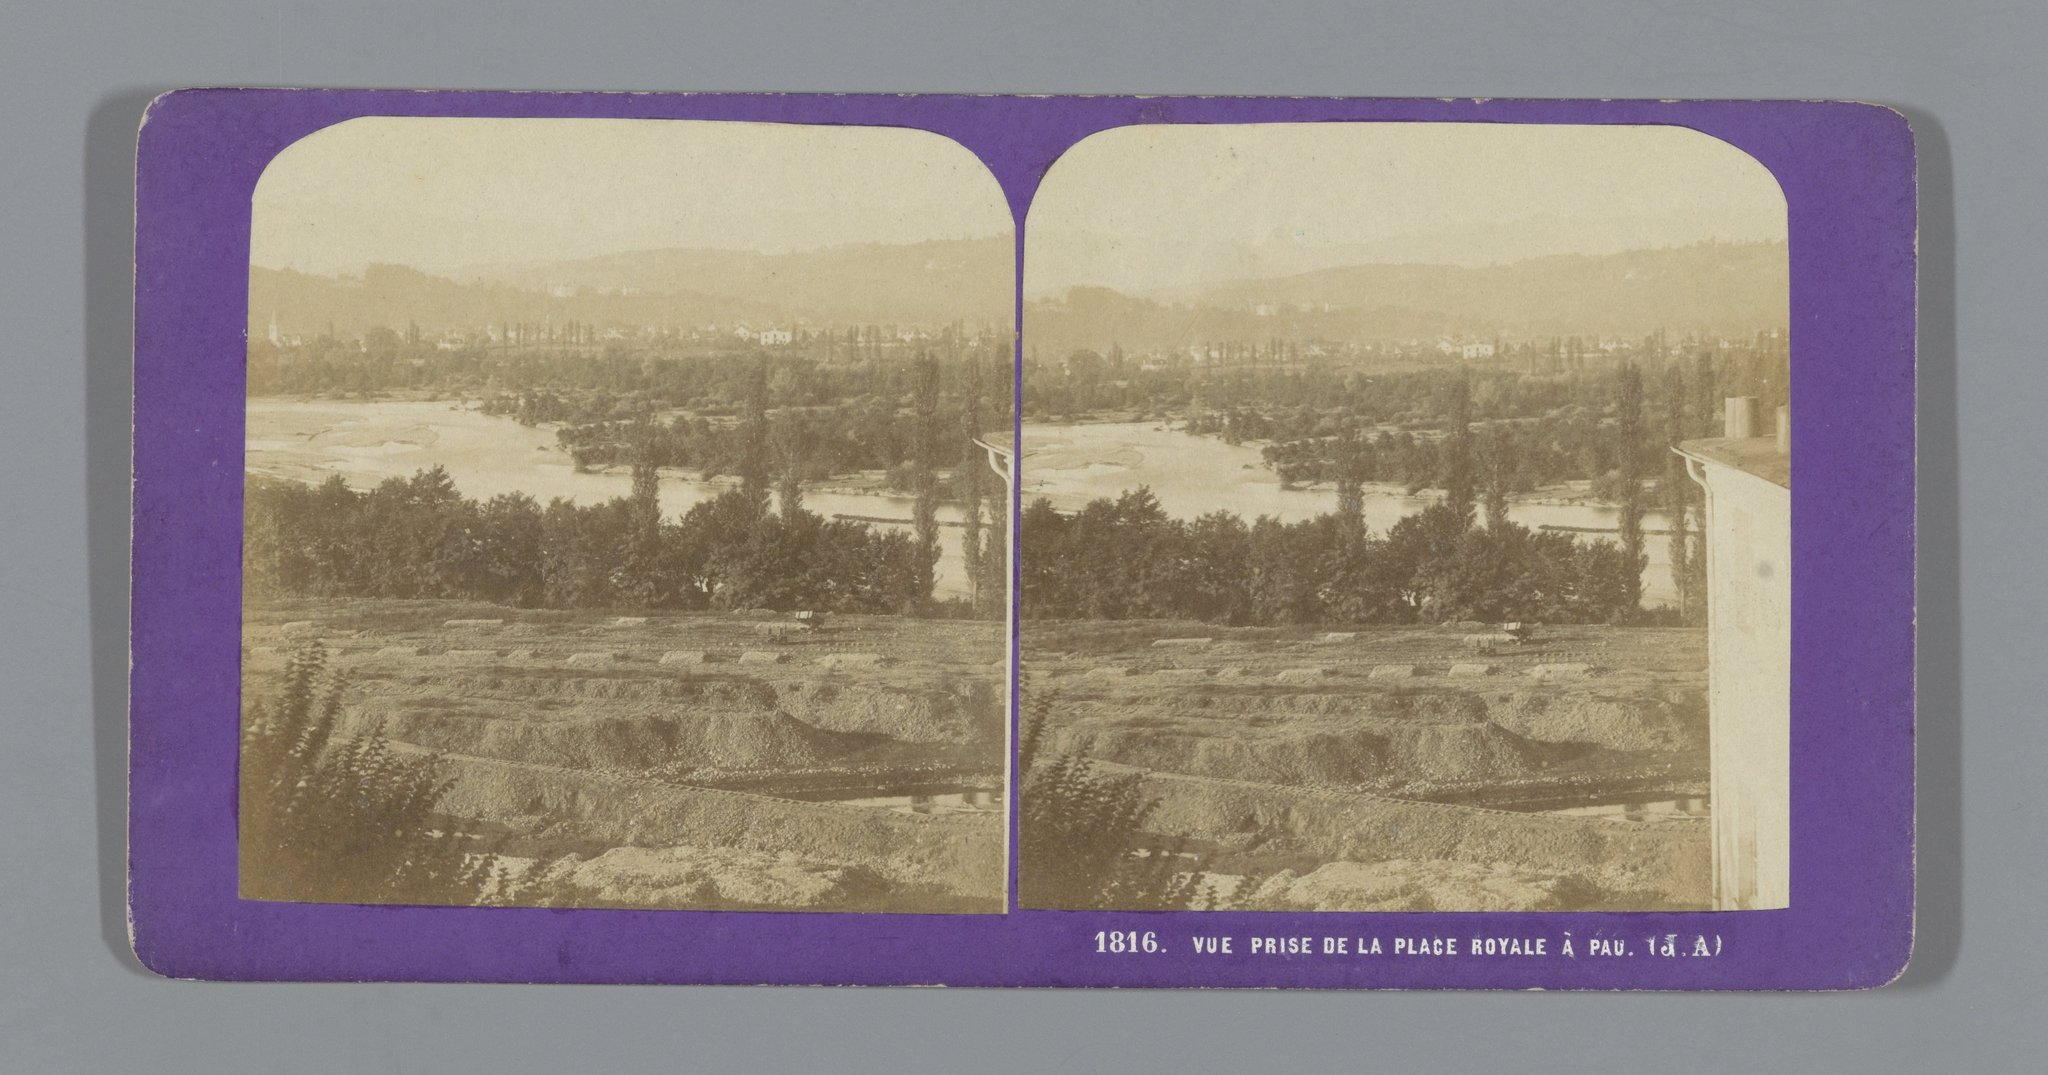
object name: stereograph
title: Gezicht op de oevers van de rivier de Ousse, gezien vanaf de Place Royale in Pau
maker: jean andrieu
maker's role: fotograaf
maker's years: 1816-1872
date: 1862-1876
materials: cardboard, paper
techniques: albumen print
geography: pau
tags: river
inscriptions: inscription: ‘ce’, number: ‘1816.’